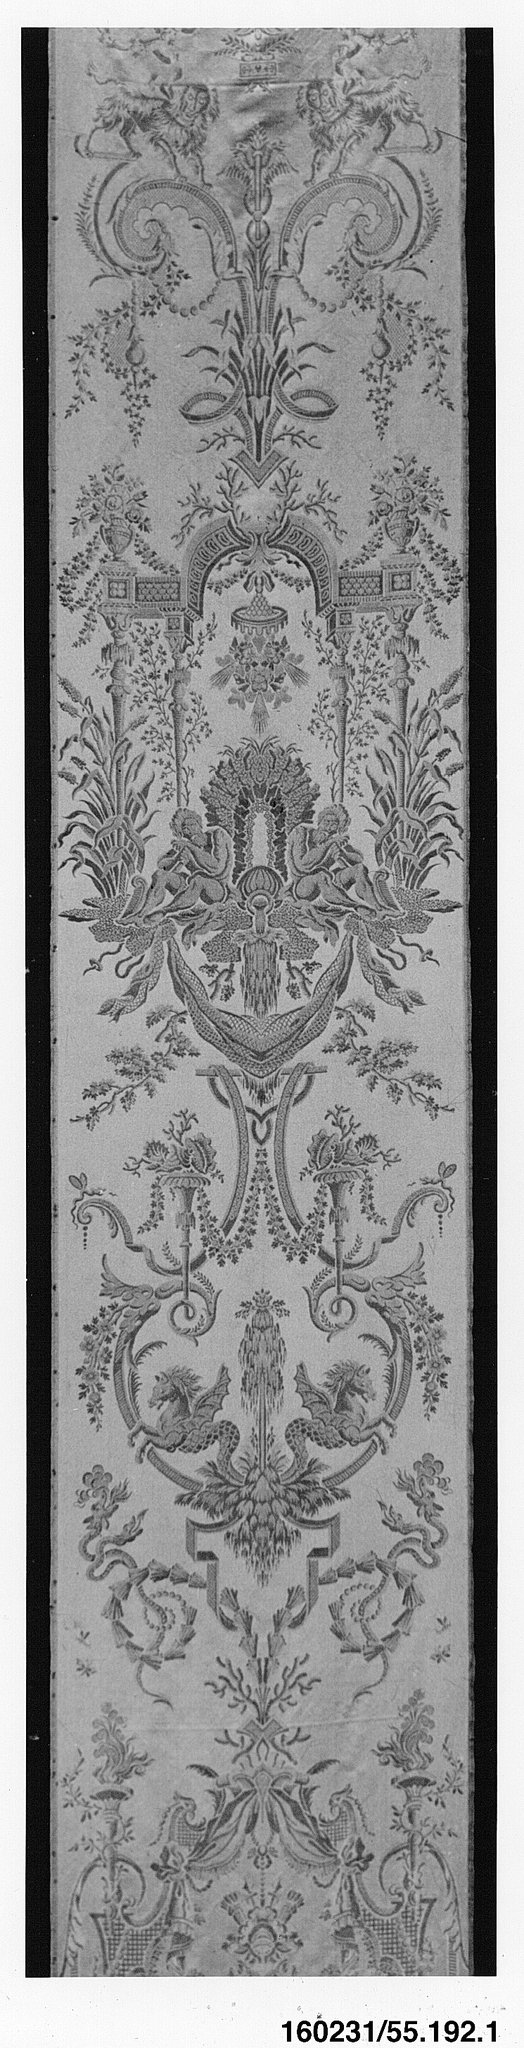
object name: panel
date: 1780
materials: silk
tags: men,dogs,snakes,seahorses